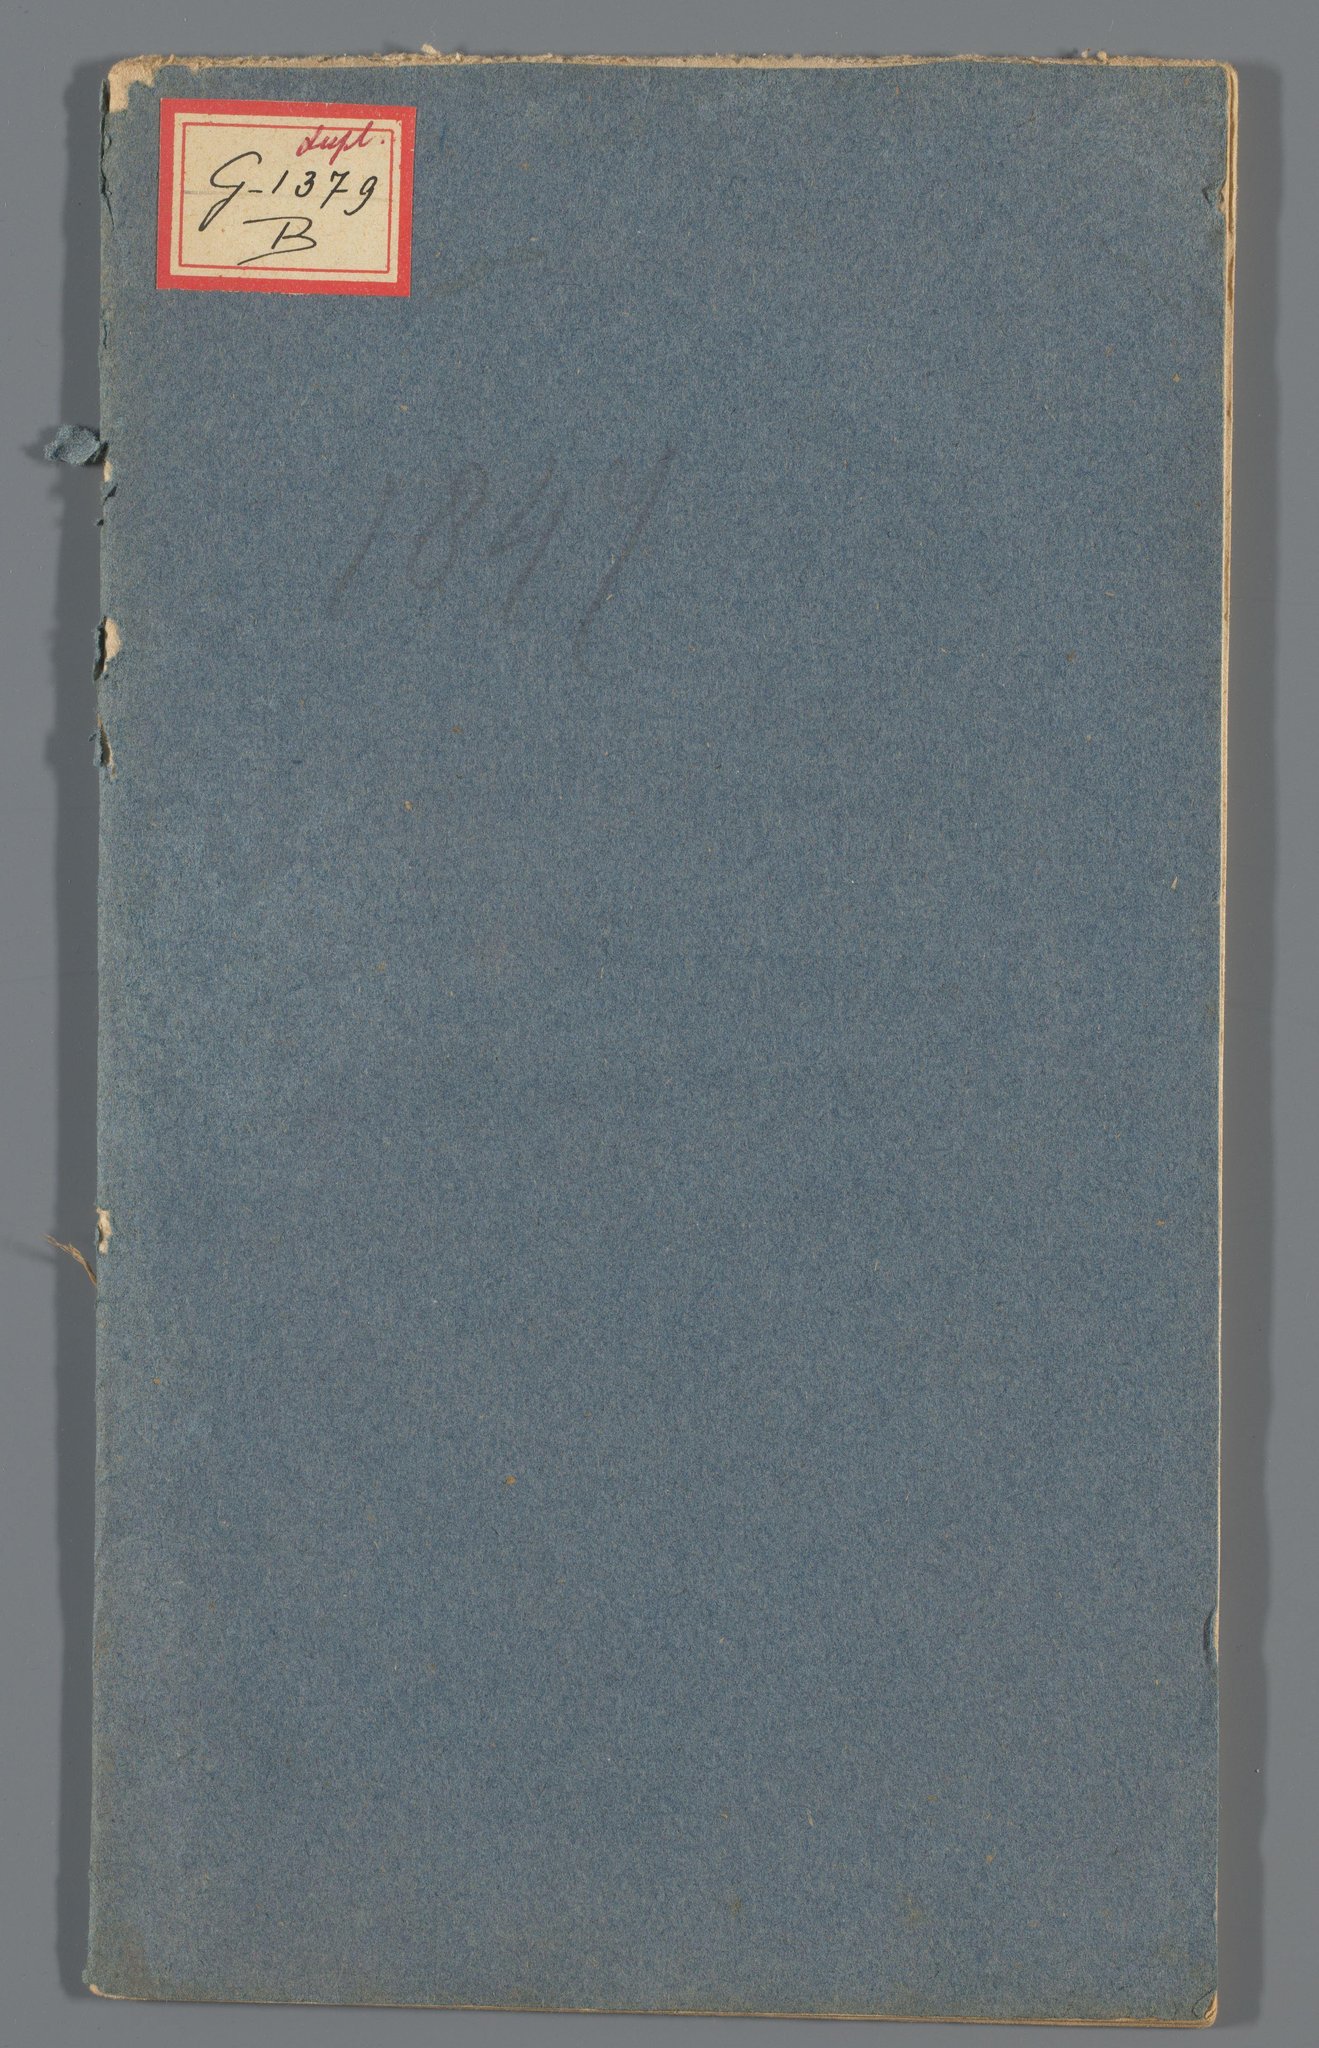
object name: brochure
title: Algemeen verslag van het verhandelde in het algemeene vergadering van hoofdbestuur (..) over Fonds ter aanmoediging en ondersteuning van gewapenden dienst in de Nederlanden.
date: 1847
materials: paper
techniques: printing, sewing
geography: amsterdam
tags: netherlands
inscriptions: date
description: 32 genummerde pp in blauwe papieren omslag, verslag van vergadering. Gedateerd; p.1.